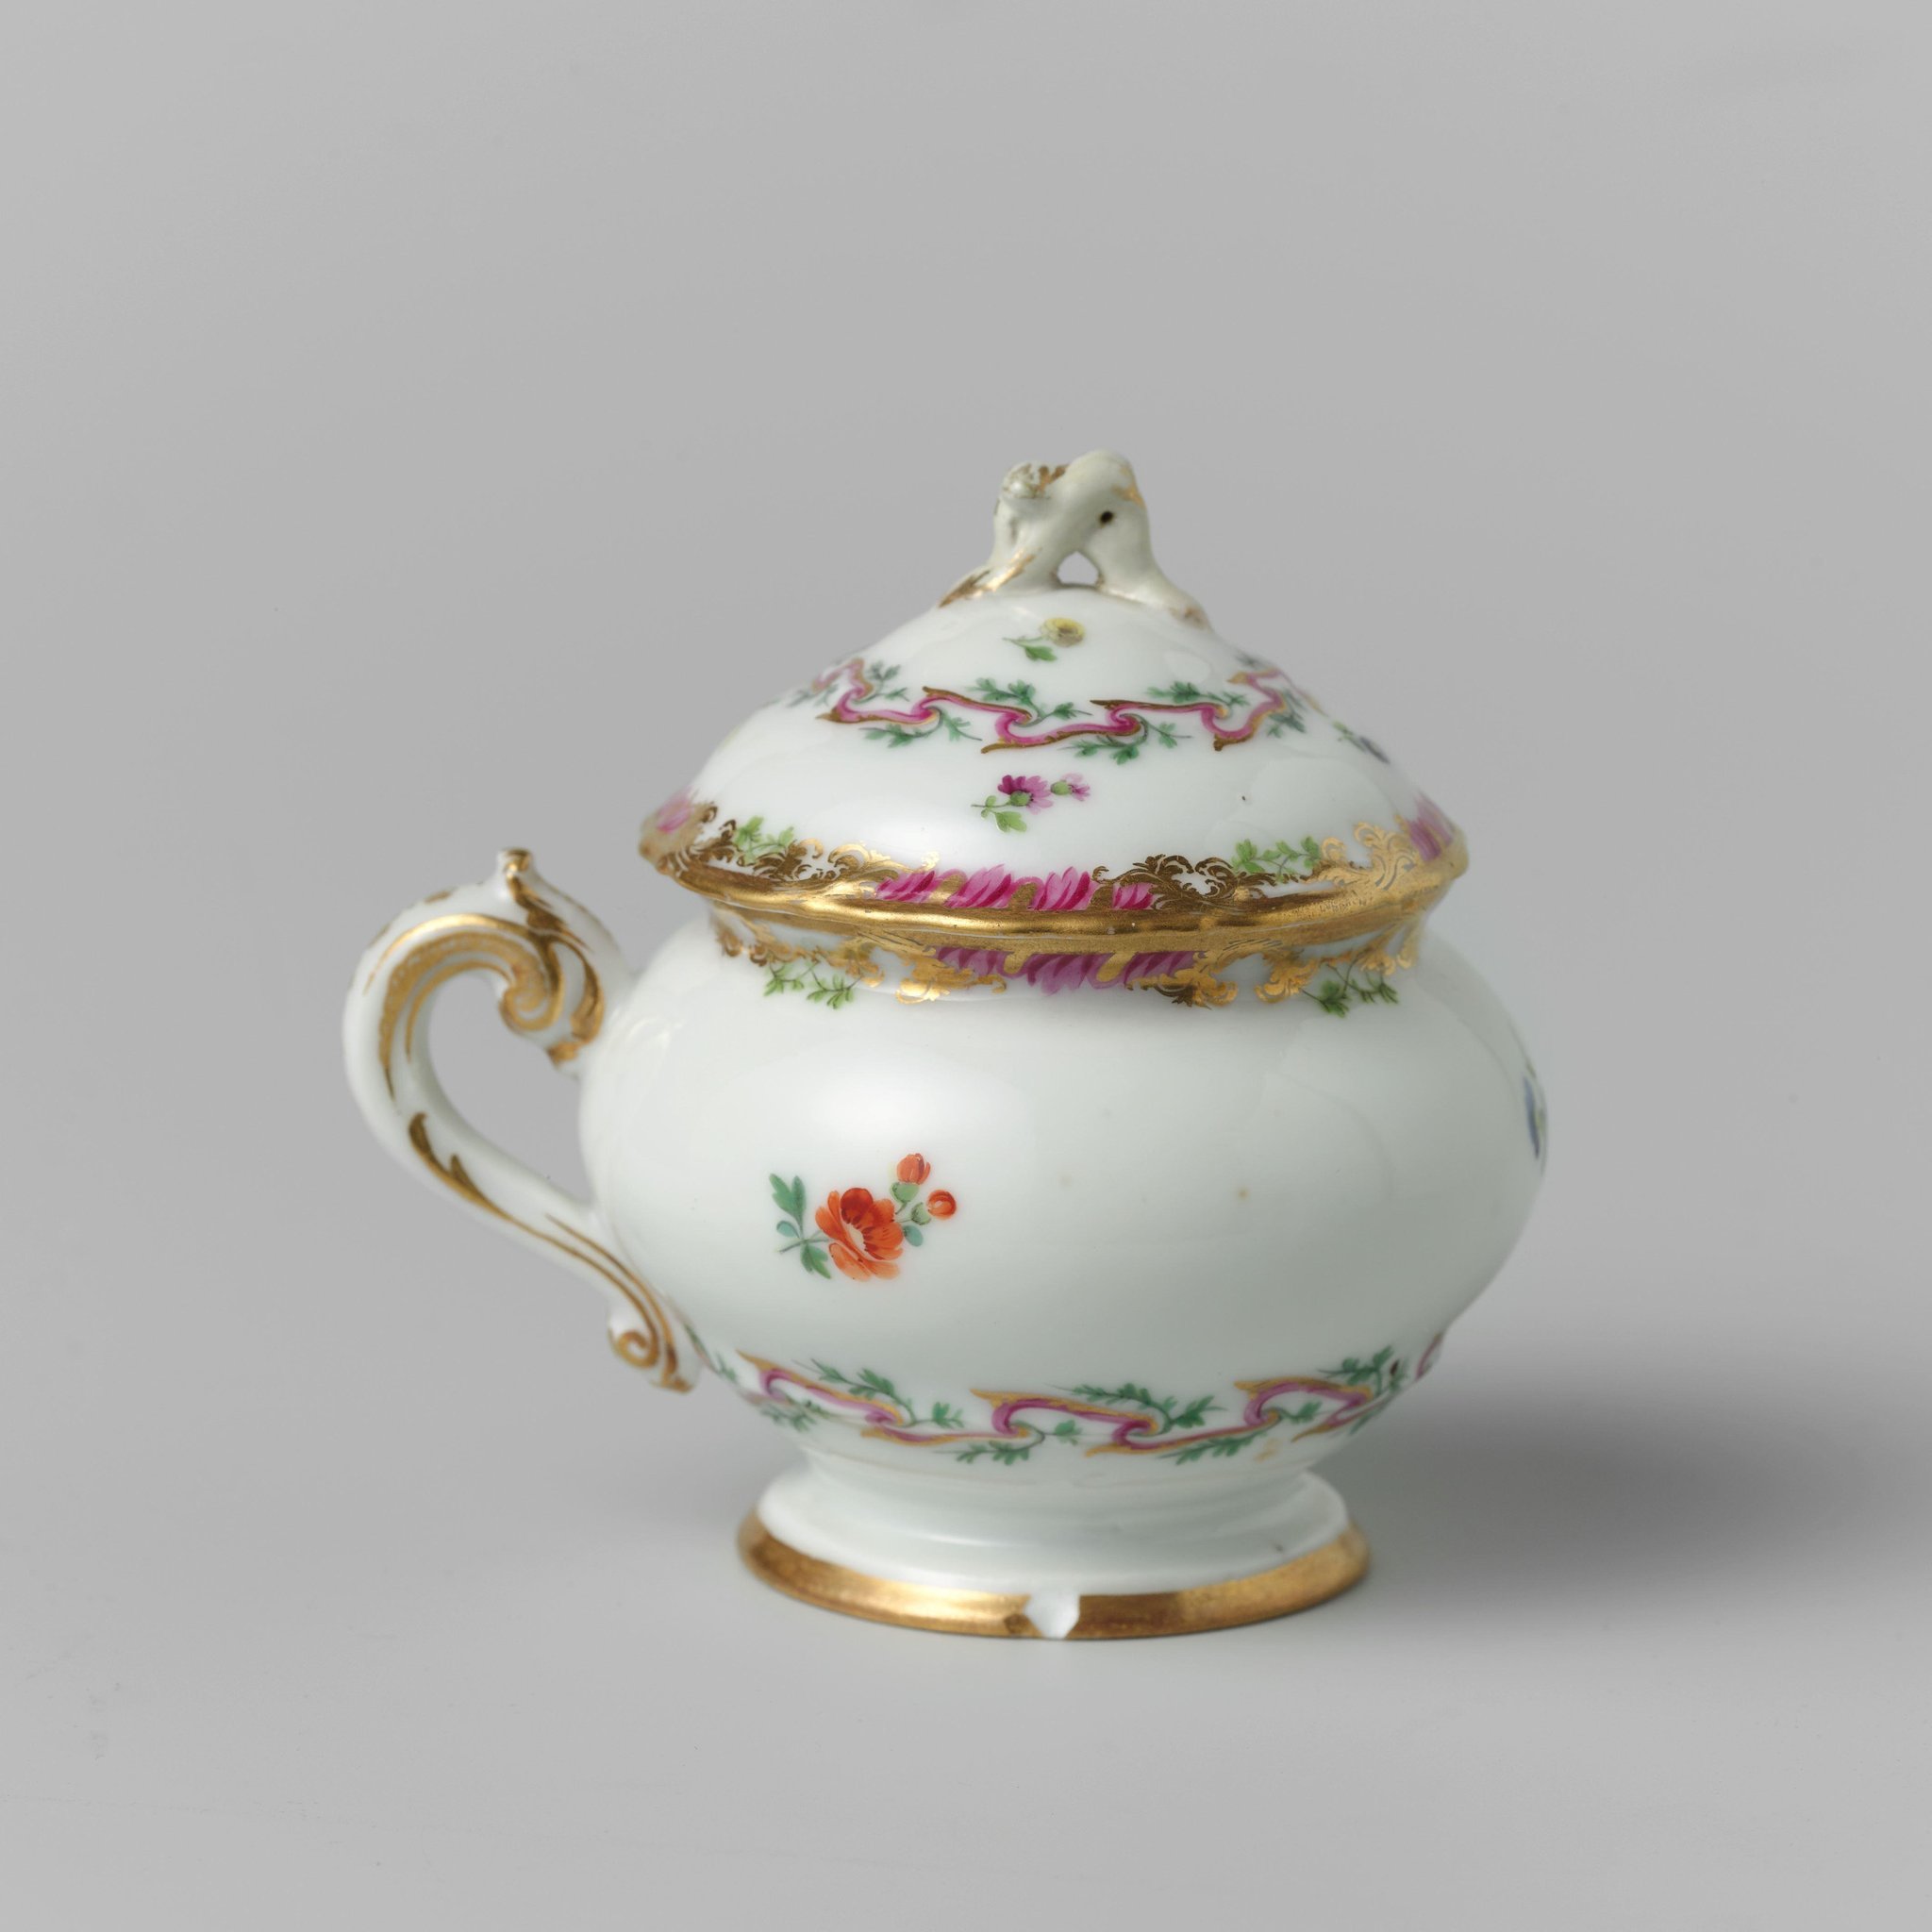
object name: lid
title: Deksel met geslingerd lintmotief met bladertakken, bloemboeketten en gestrooide bloemtakken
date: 1780-1820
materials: porcelain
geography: amsterdam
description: Deksel, behorend bij een servies van porselein met geslingerd motief in paars en goud met groene bladertakken, bloemboeketten en gestrooide bloemtakken. Randen lichtgegolfd met decoratie in goud met paars bladmotief waartussen groen gekruist bladmotief. Gemerkt: M.O.L. en AMSTEL. Serie van elf stuks.